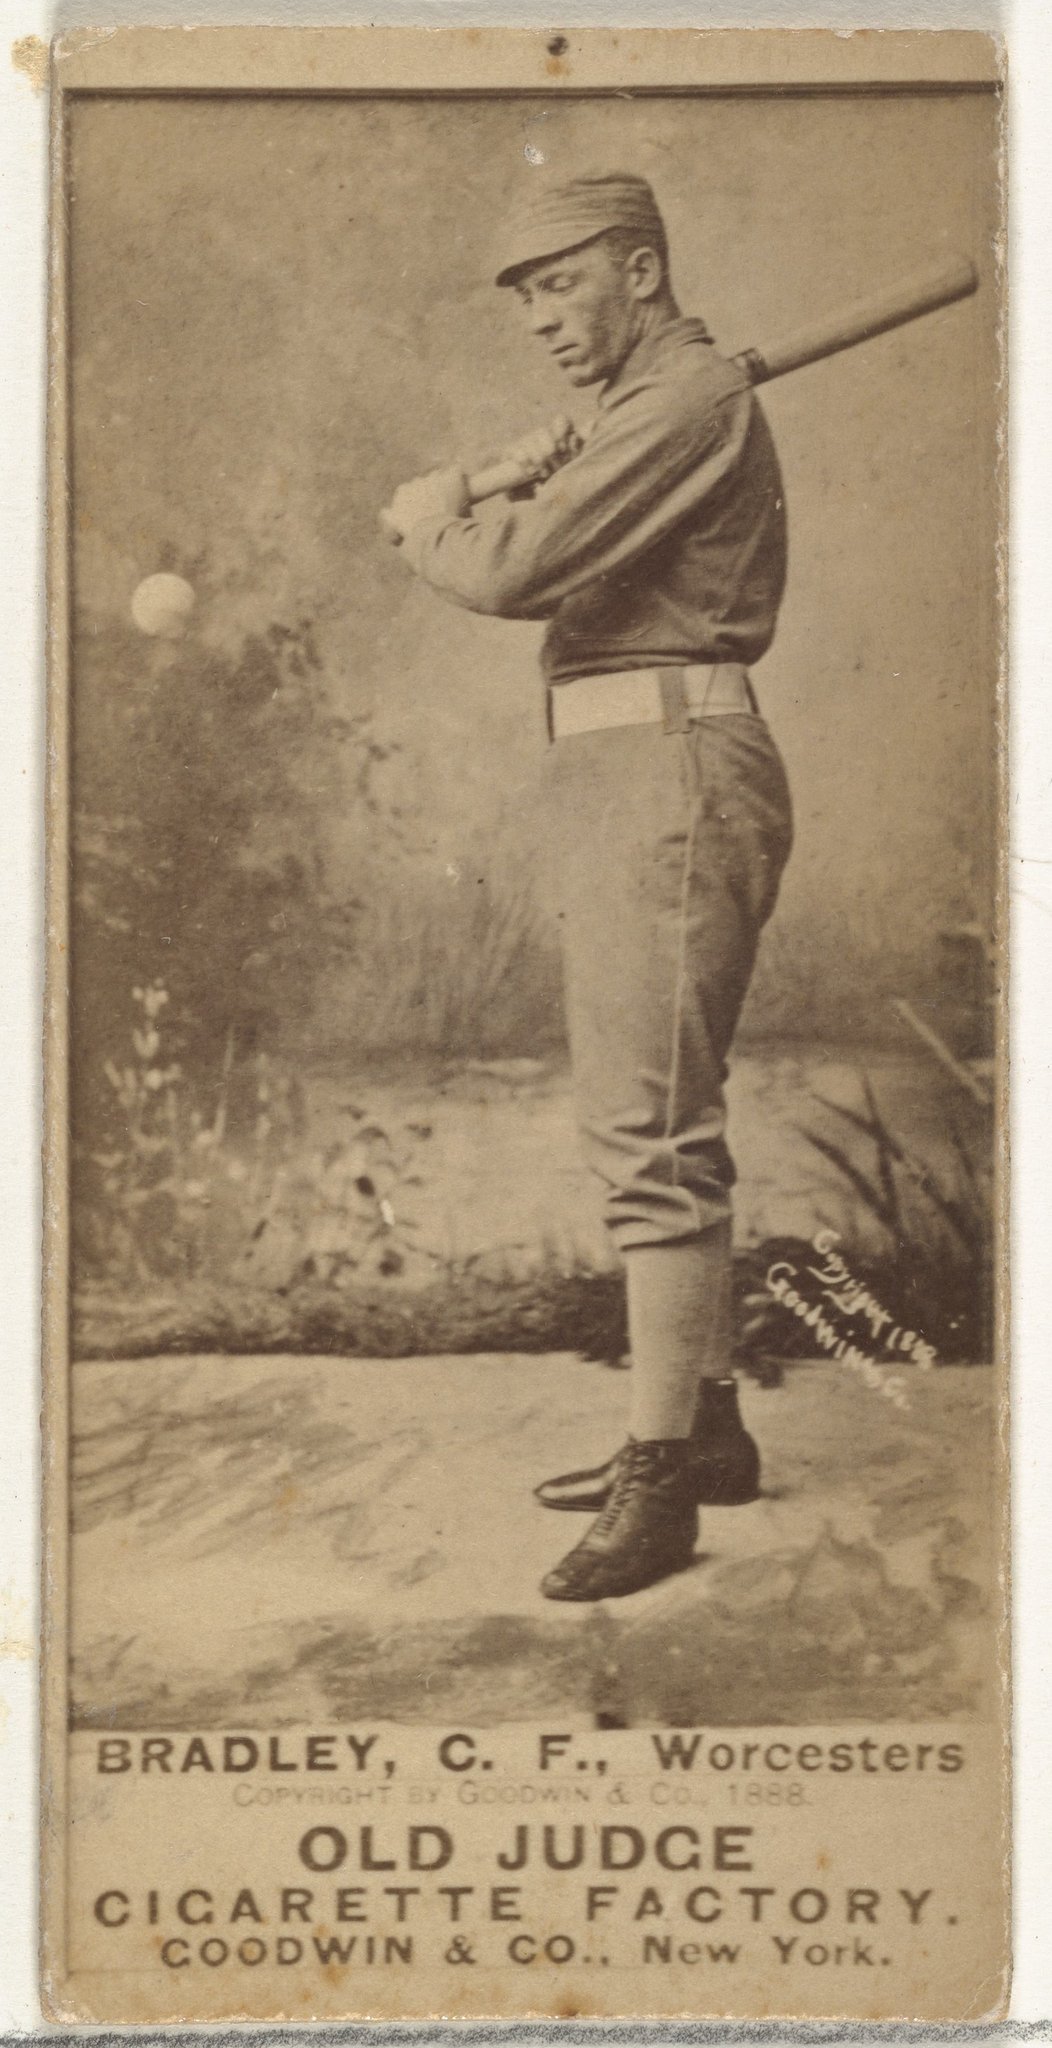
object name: baseball card, photograph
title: Bradley, Center Field, Worcester, from the Old Judge series (N172) for Old Judge Cigarettes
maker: goodwin & company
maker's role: publisher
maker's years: 1850-1950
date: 1888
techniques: albumen silver print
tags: men,portraits,baseball,athletes